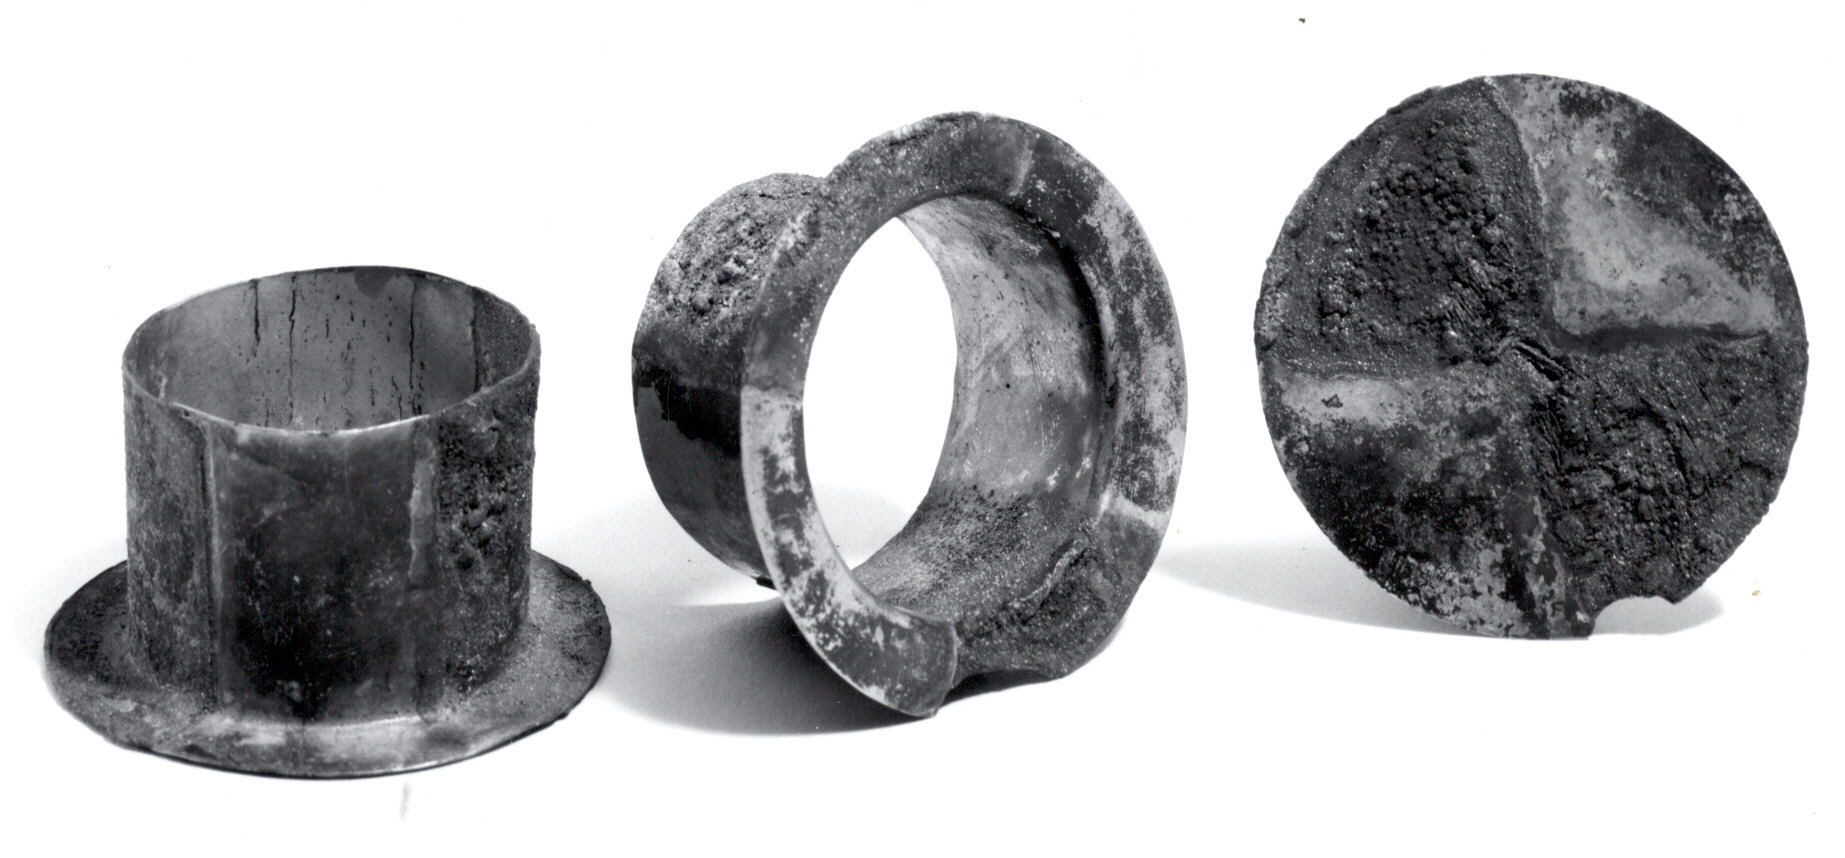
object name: earflare frontal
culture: lambayeque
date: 100 BCE-700 CE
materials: gold, silver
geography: peru